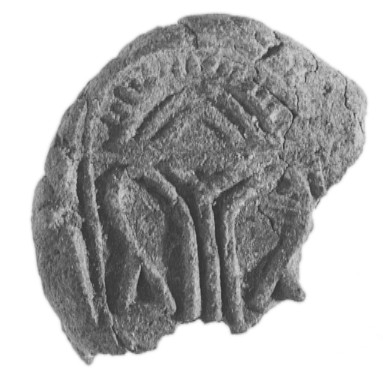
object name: sealing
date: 2030-1640 BCE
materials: clay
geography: egypt